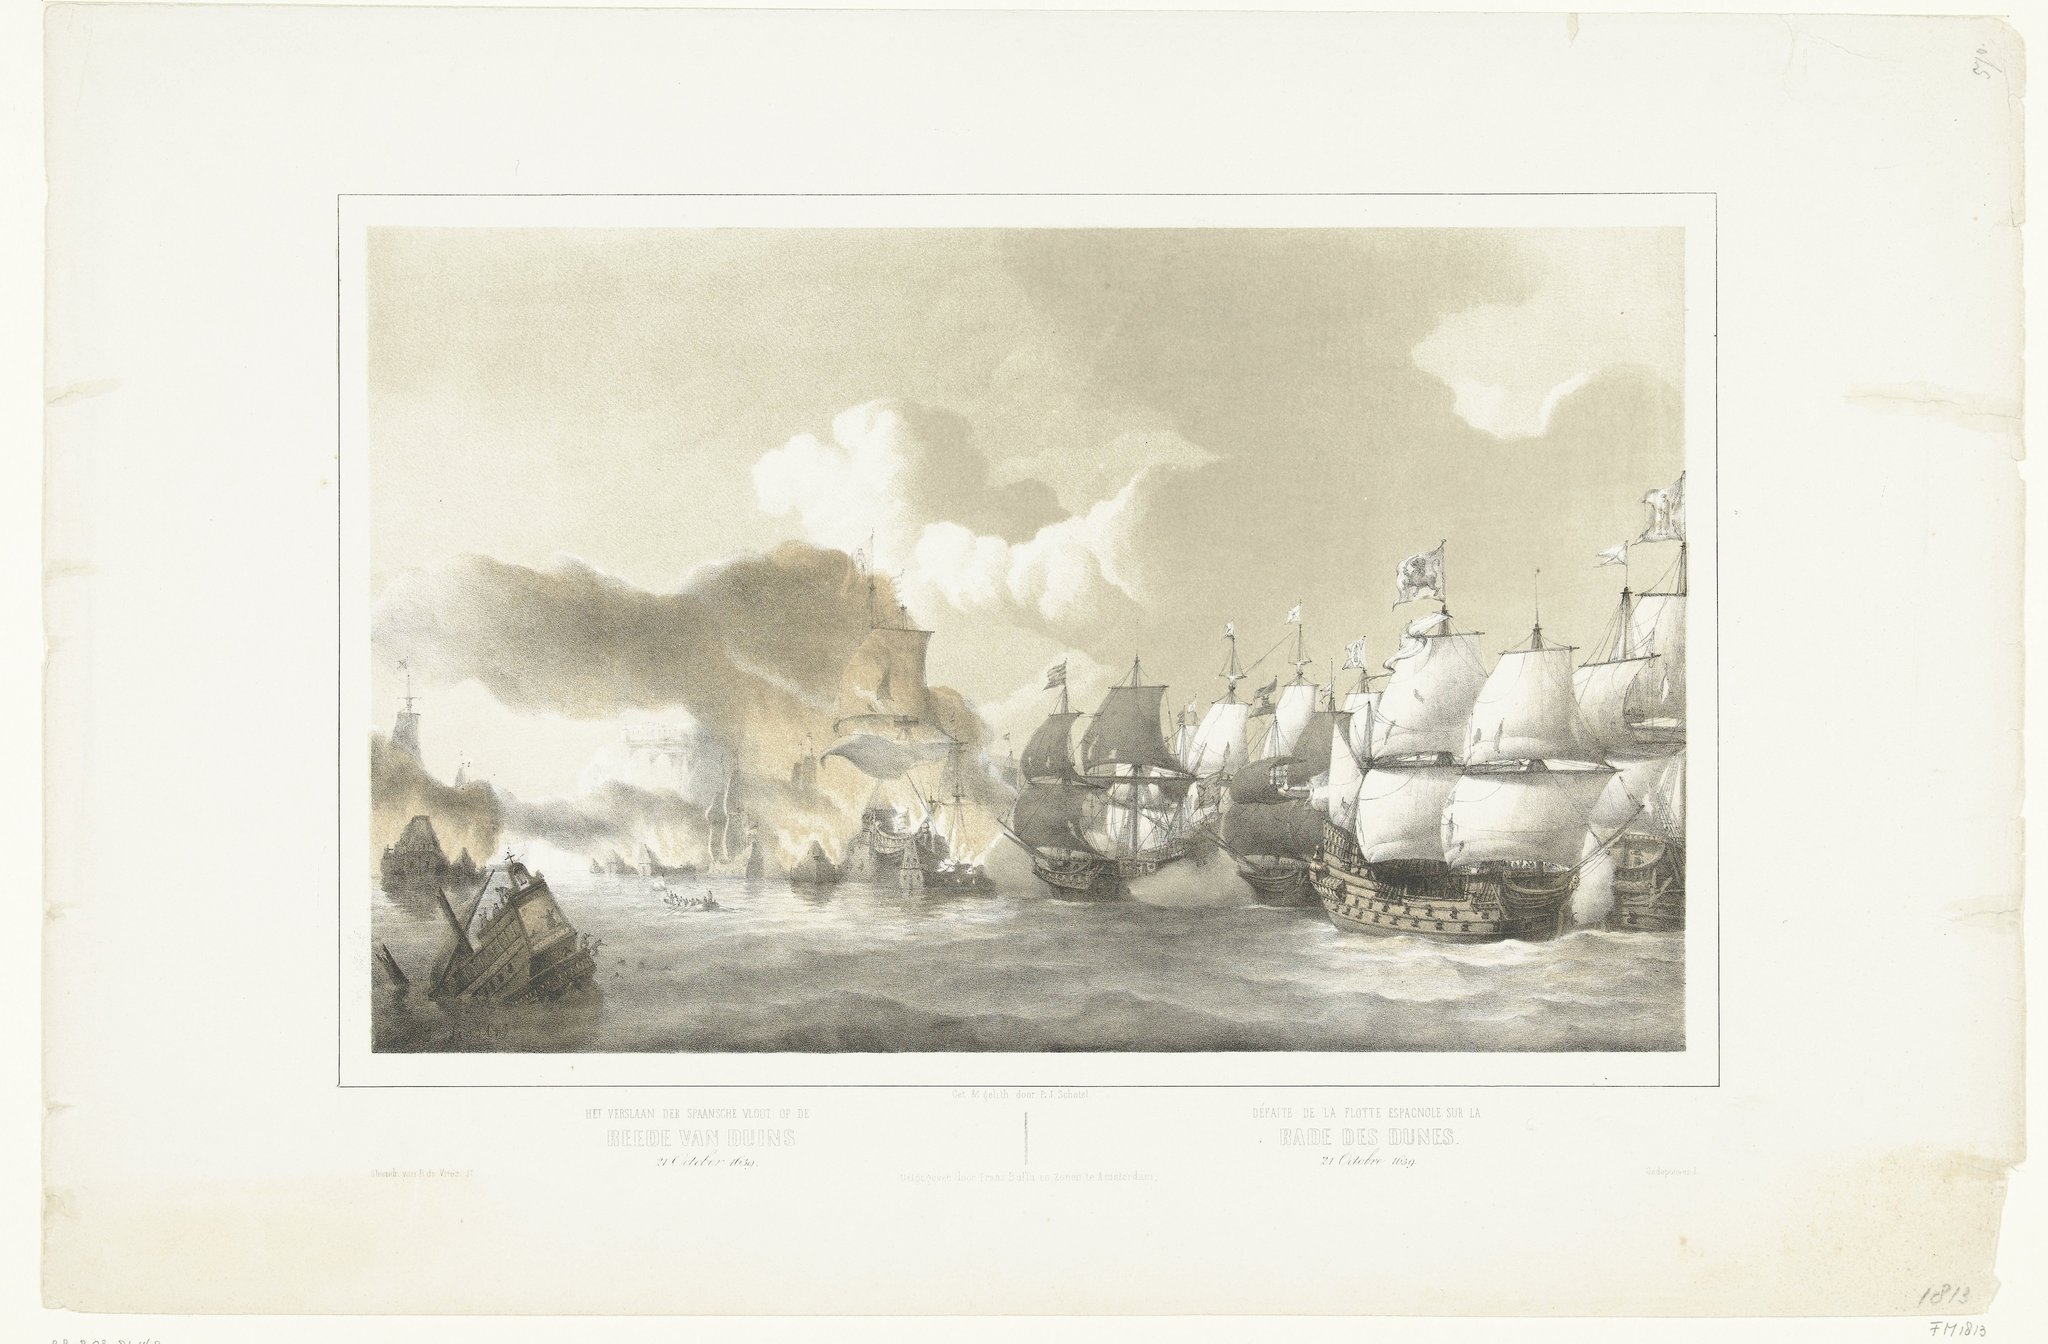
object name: history print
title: Spaanse vloot verslagen in de zeeslag bij Duins, 1639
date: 1848-1855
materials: paper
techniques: lithograph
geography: amsterdam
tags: maarten harpertszoon tromp, battle (+ naval force), battle of the downs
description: Uitgegeven in: P.J. Schotel, Heldendaden der Nederlanders ter zee, van de vroegste tijden tot op heden, naar aanleiding van de: Geschiedenis van het Nederlandsche zeewezen, Frans Buffa en Zonen, Amsterdam 1850-1855, pl. 13. Zonder de uitvoerige beschrijving vermeld bij Muller.